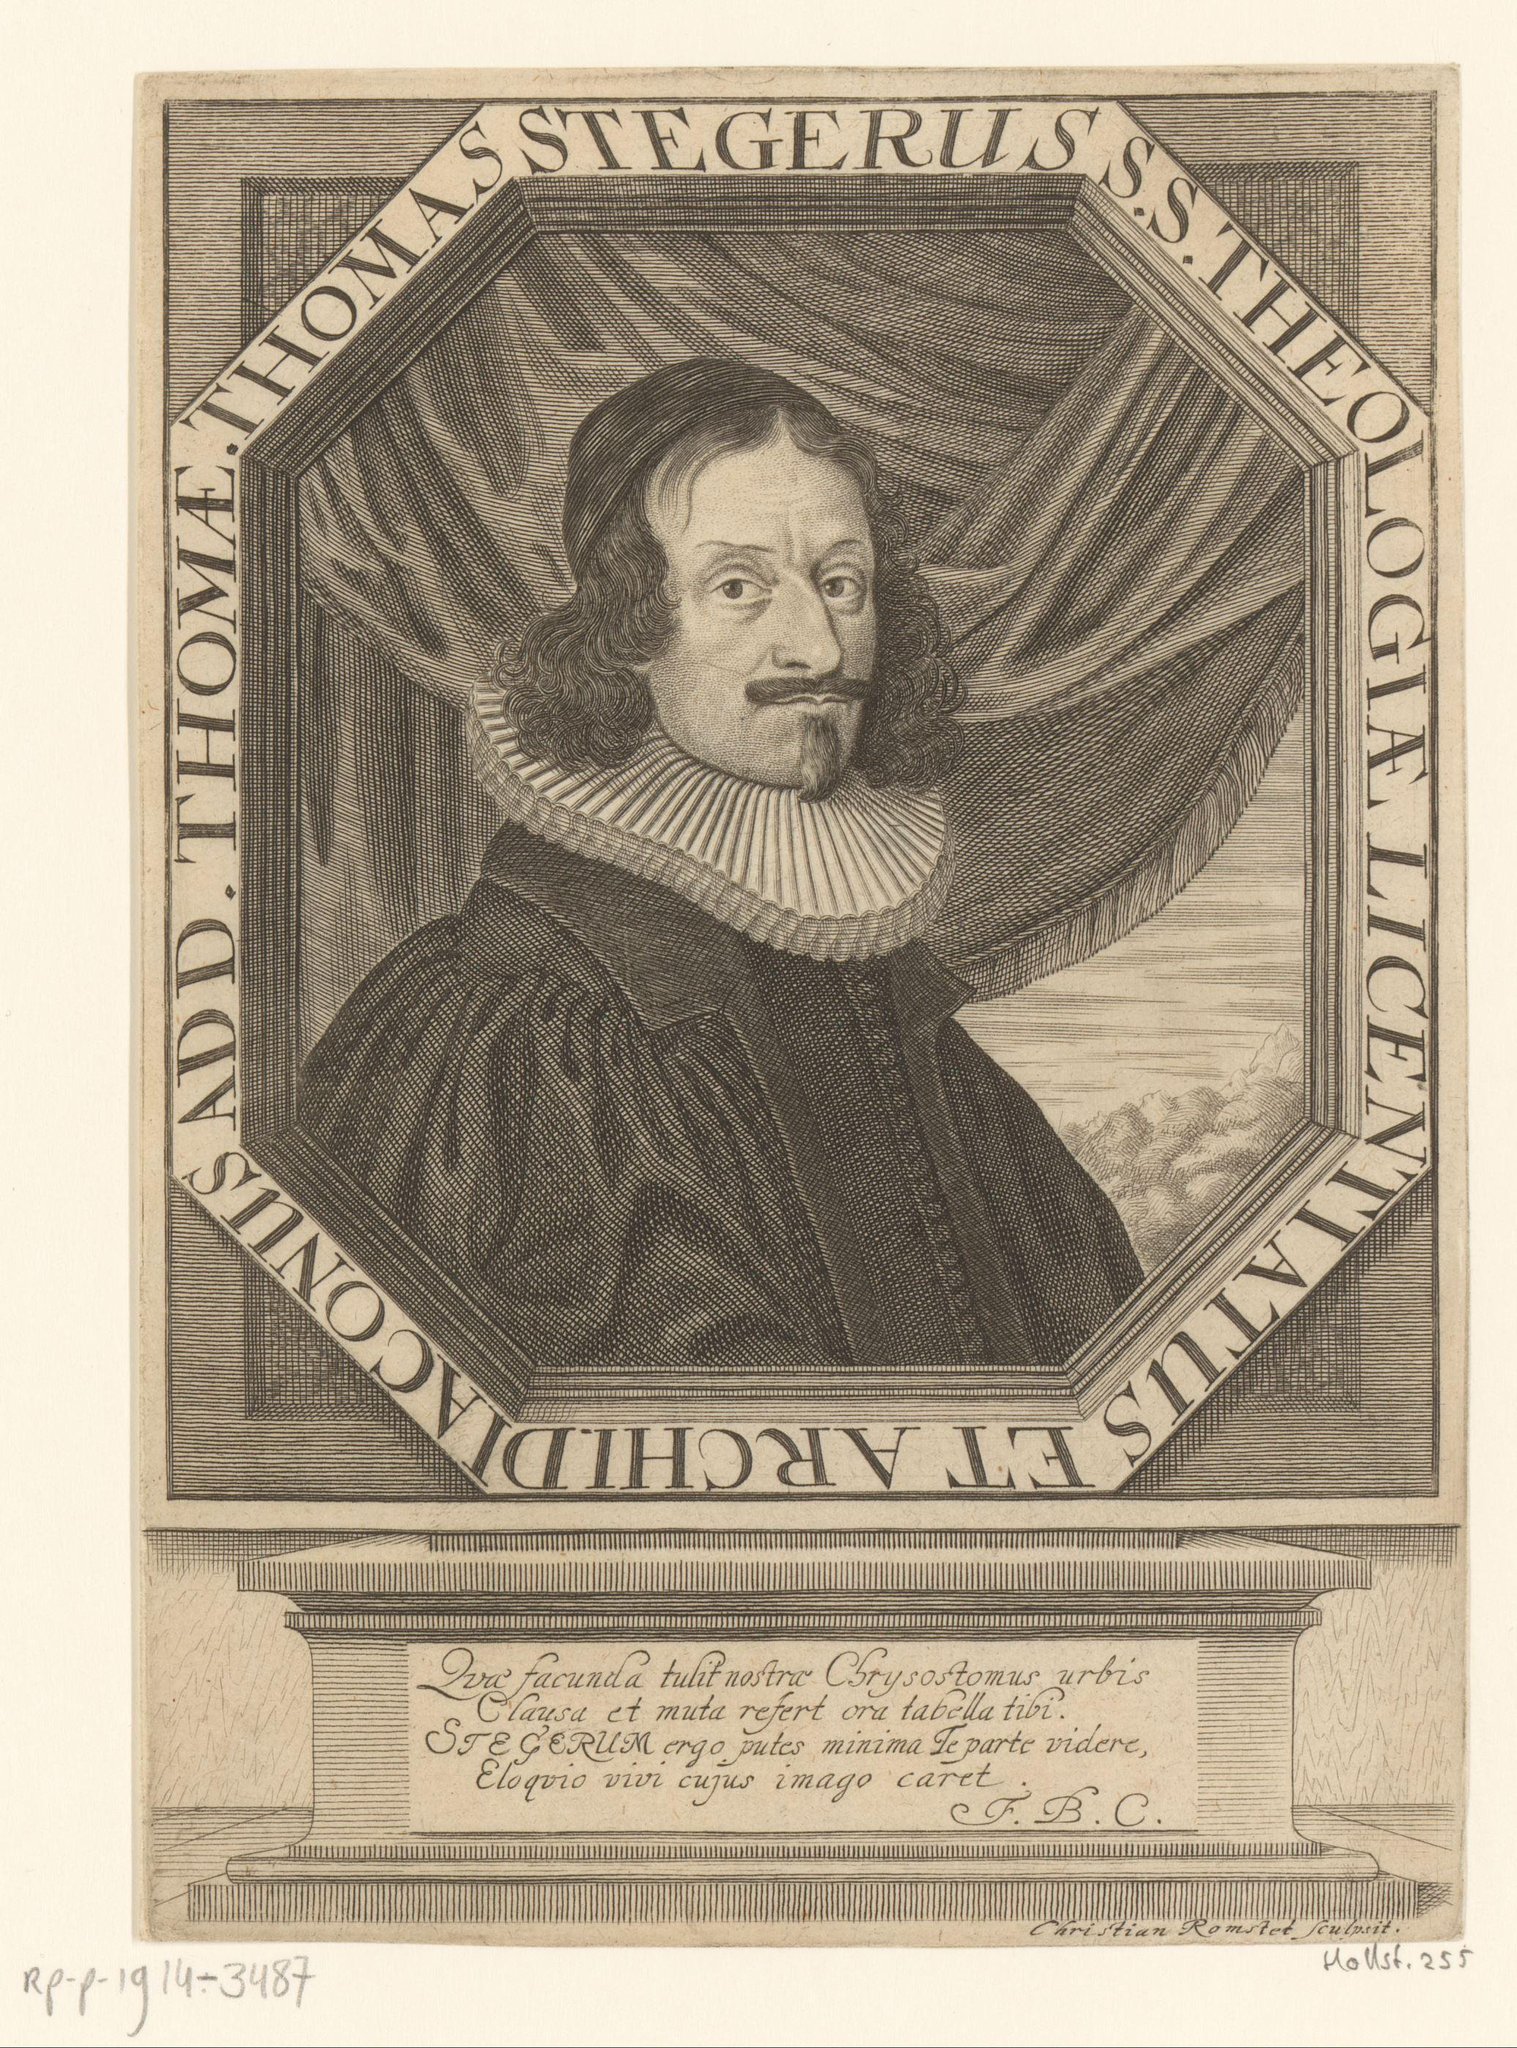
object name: print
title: Portret van Thomas Steger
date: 1665-1721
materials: paper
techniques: engraving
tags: historical persons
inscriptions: collector's mark: Lugt 2228